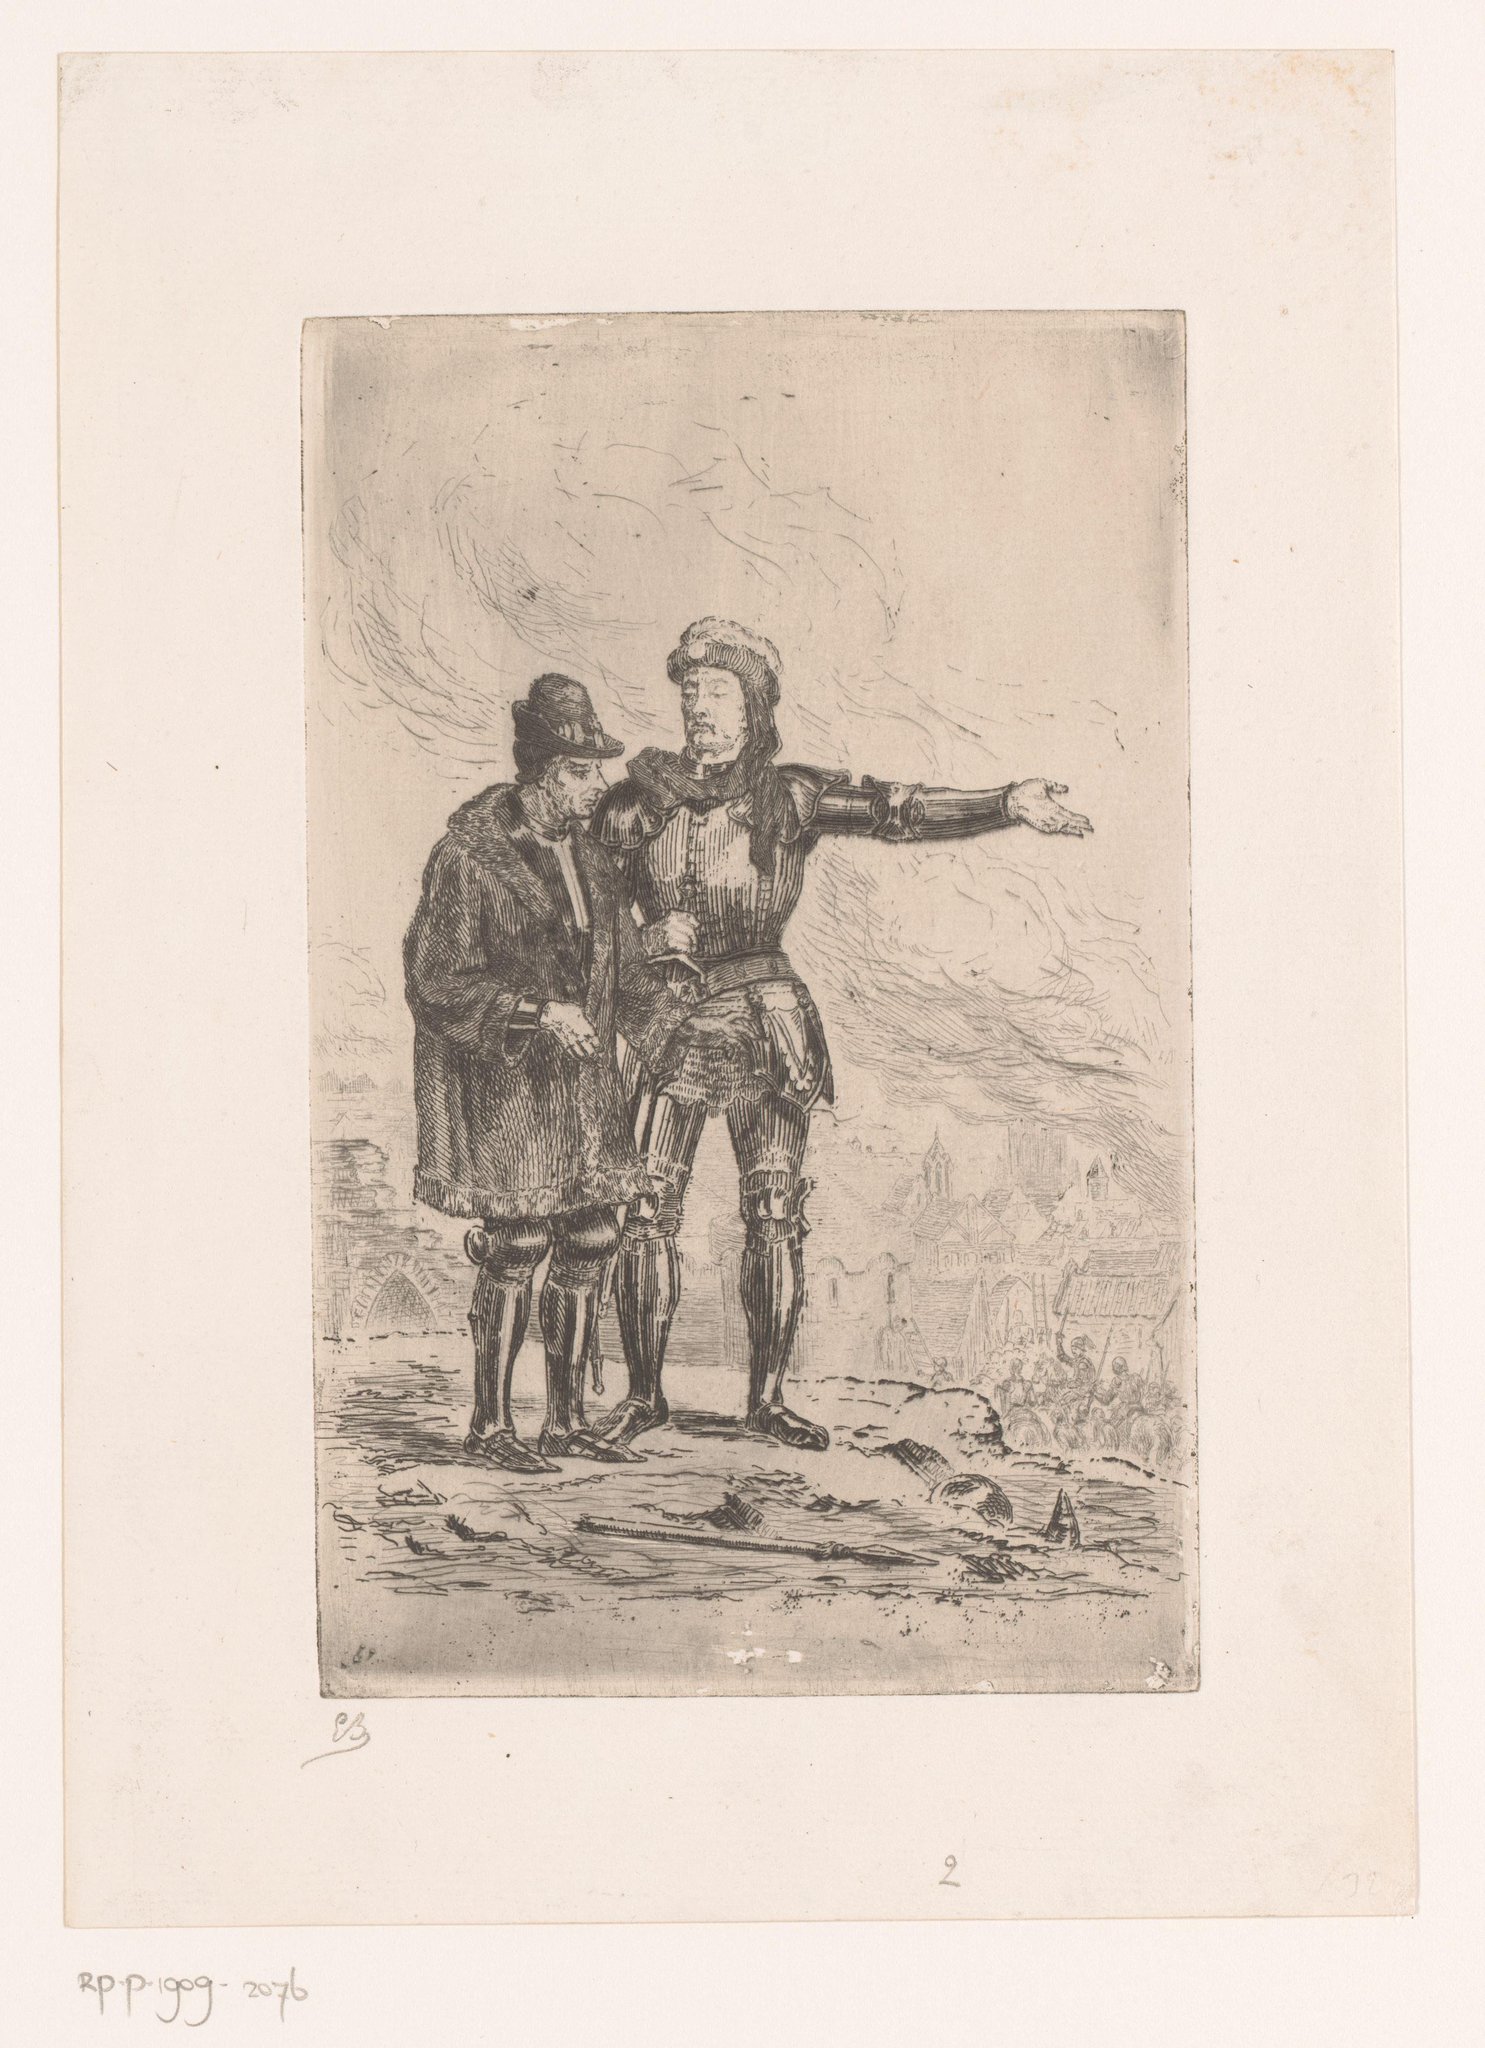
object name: print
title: Scène uit de roman Quinten Durward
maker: edgar alfred baes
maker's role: print maker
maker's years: 1837-1909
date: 1847-1909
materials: paper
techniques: drypoint, etching, intaglio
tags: siege, knight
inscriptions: collector's mark: Lugt 2228